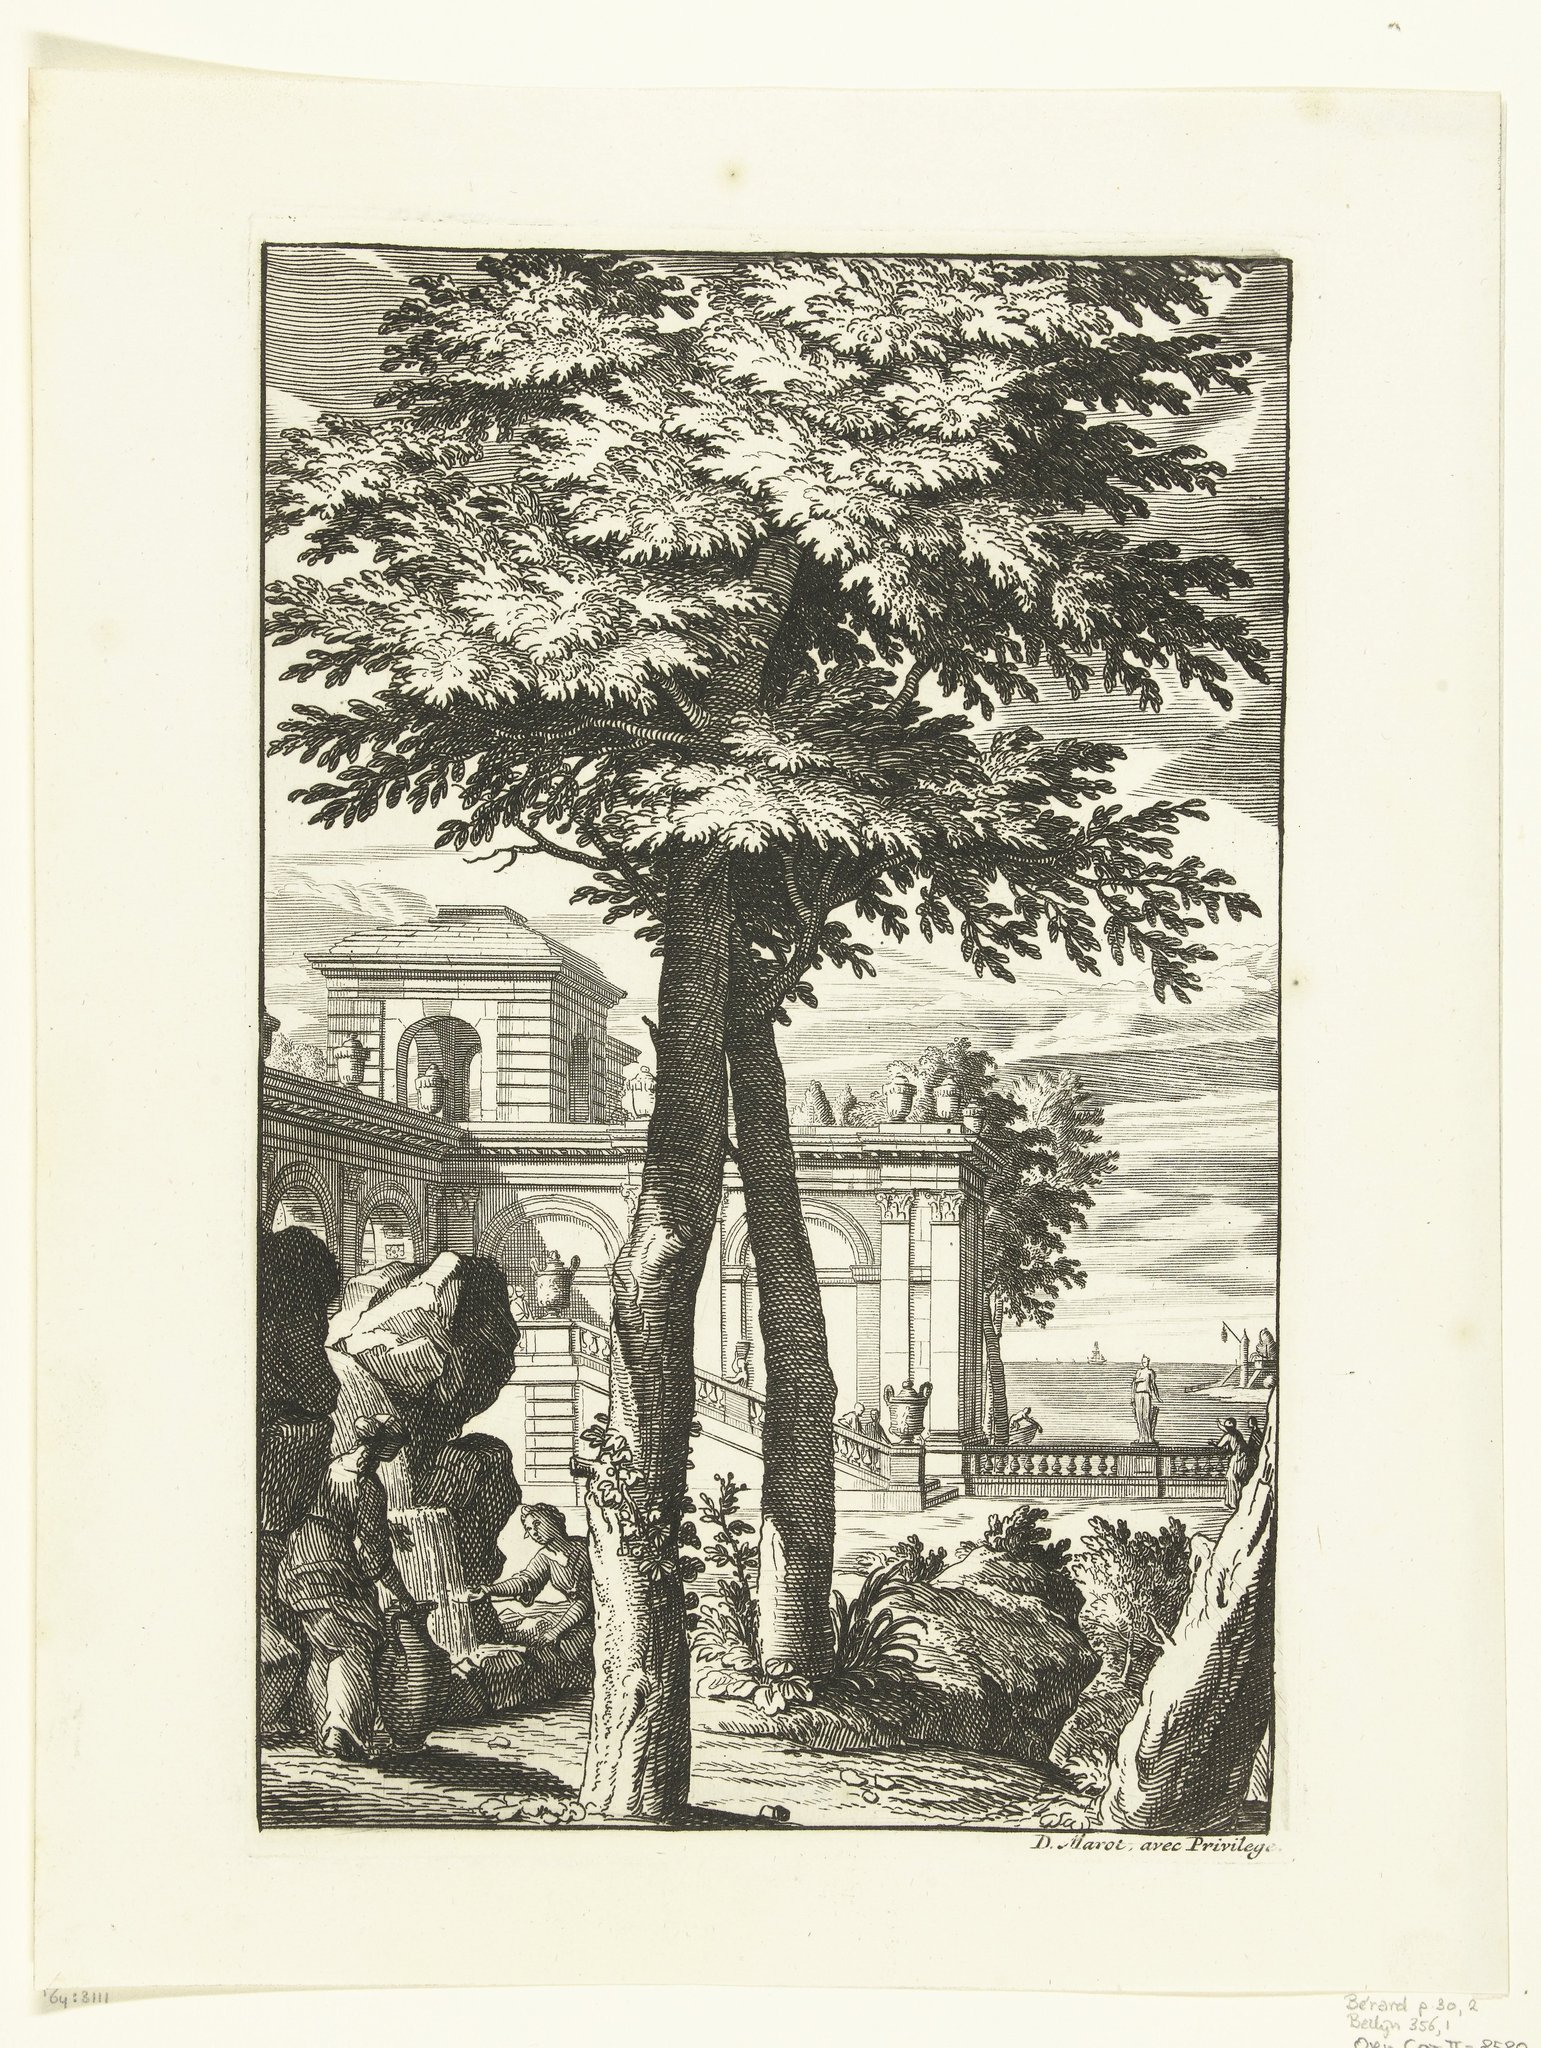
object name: ornament print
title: Landschap met vooraan twee bomen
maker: daniël marot (i)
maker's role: draughtsman, print maker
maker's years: 1661-1752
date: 1703-1712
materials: paper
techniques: etching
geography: netherlands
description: Links staan twee vrouwen naast een cascade. Op de achtergrond is een paleis te zien met rechts daarvan uitzicht op zee. Uit serie van 6 bladen.